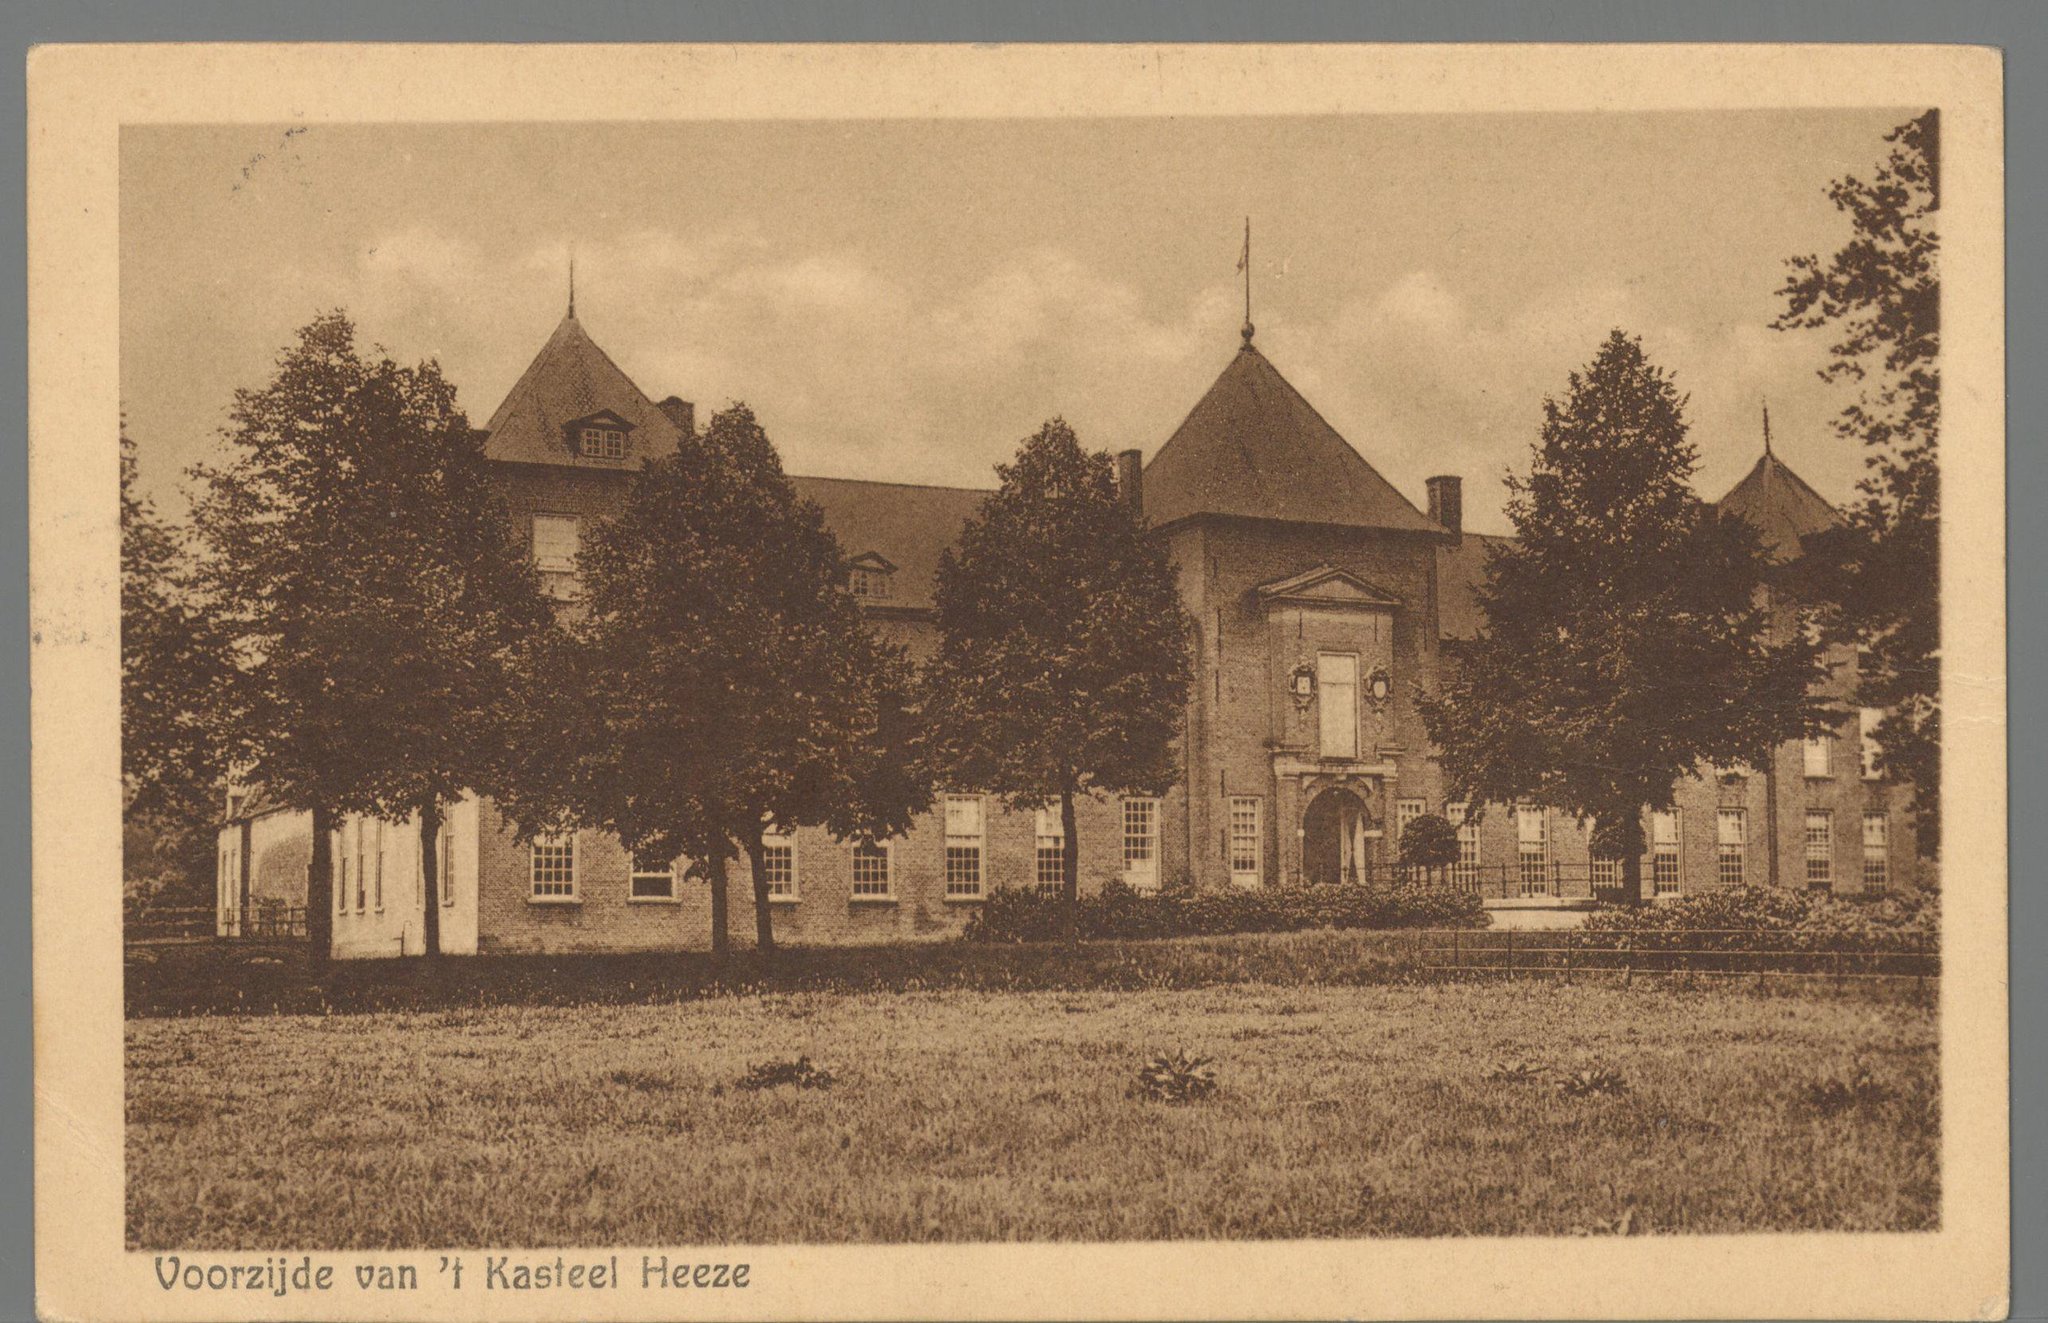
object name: photomechanical print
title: Voorzijde van 't Kasteel Heeze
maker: Anonymous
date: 1913-1928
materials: cardboard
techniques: photograph, writing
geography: heeze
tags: castle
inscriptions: postage stamp